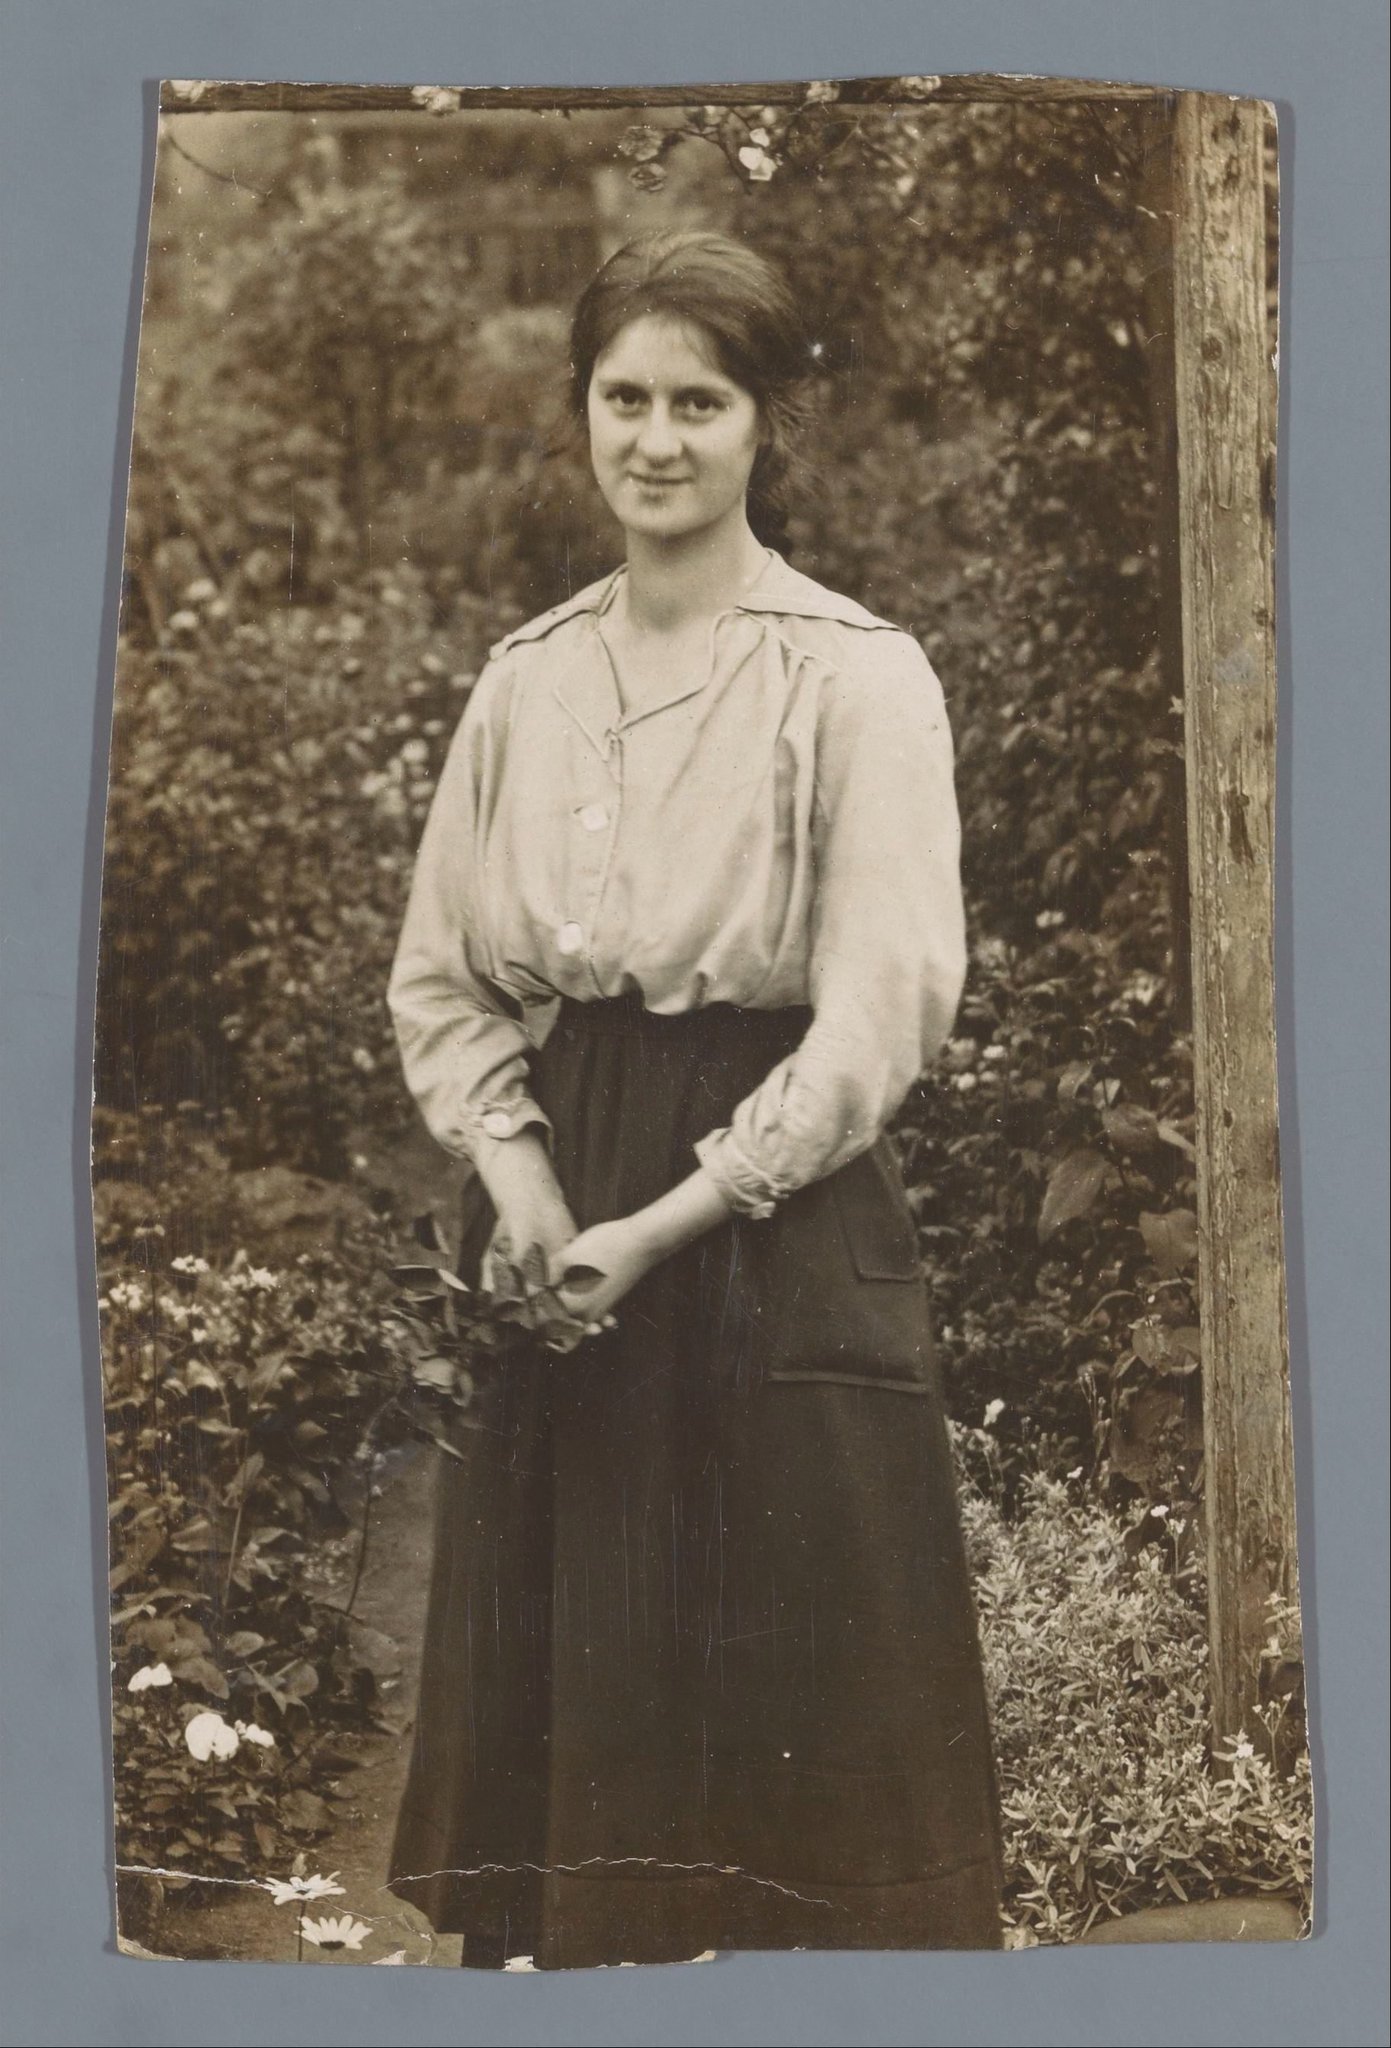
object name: photograph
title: Portret van een onbekende vrouw in een tuin met bloemen in haar hand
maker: Anonymous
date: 1920-1940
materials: photographic support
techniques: gelatin silver print, snipping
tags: adolescent, young woman, maiden, cut flowers; nosegay, bunch of flowers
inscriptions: inscription: ‘Post Card This Space for communication The Address to be written here’